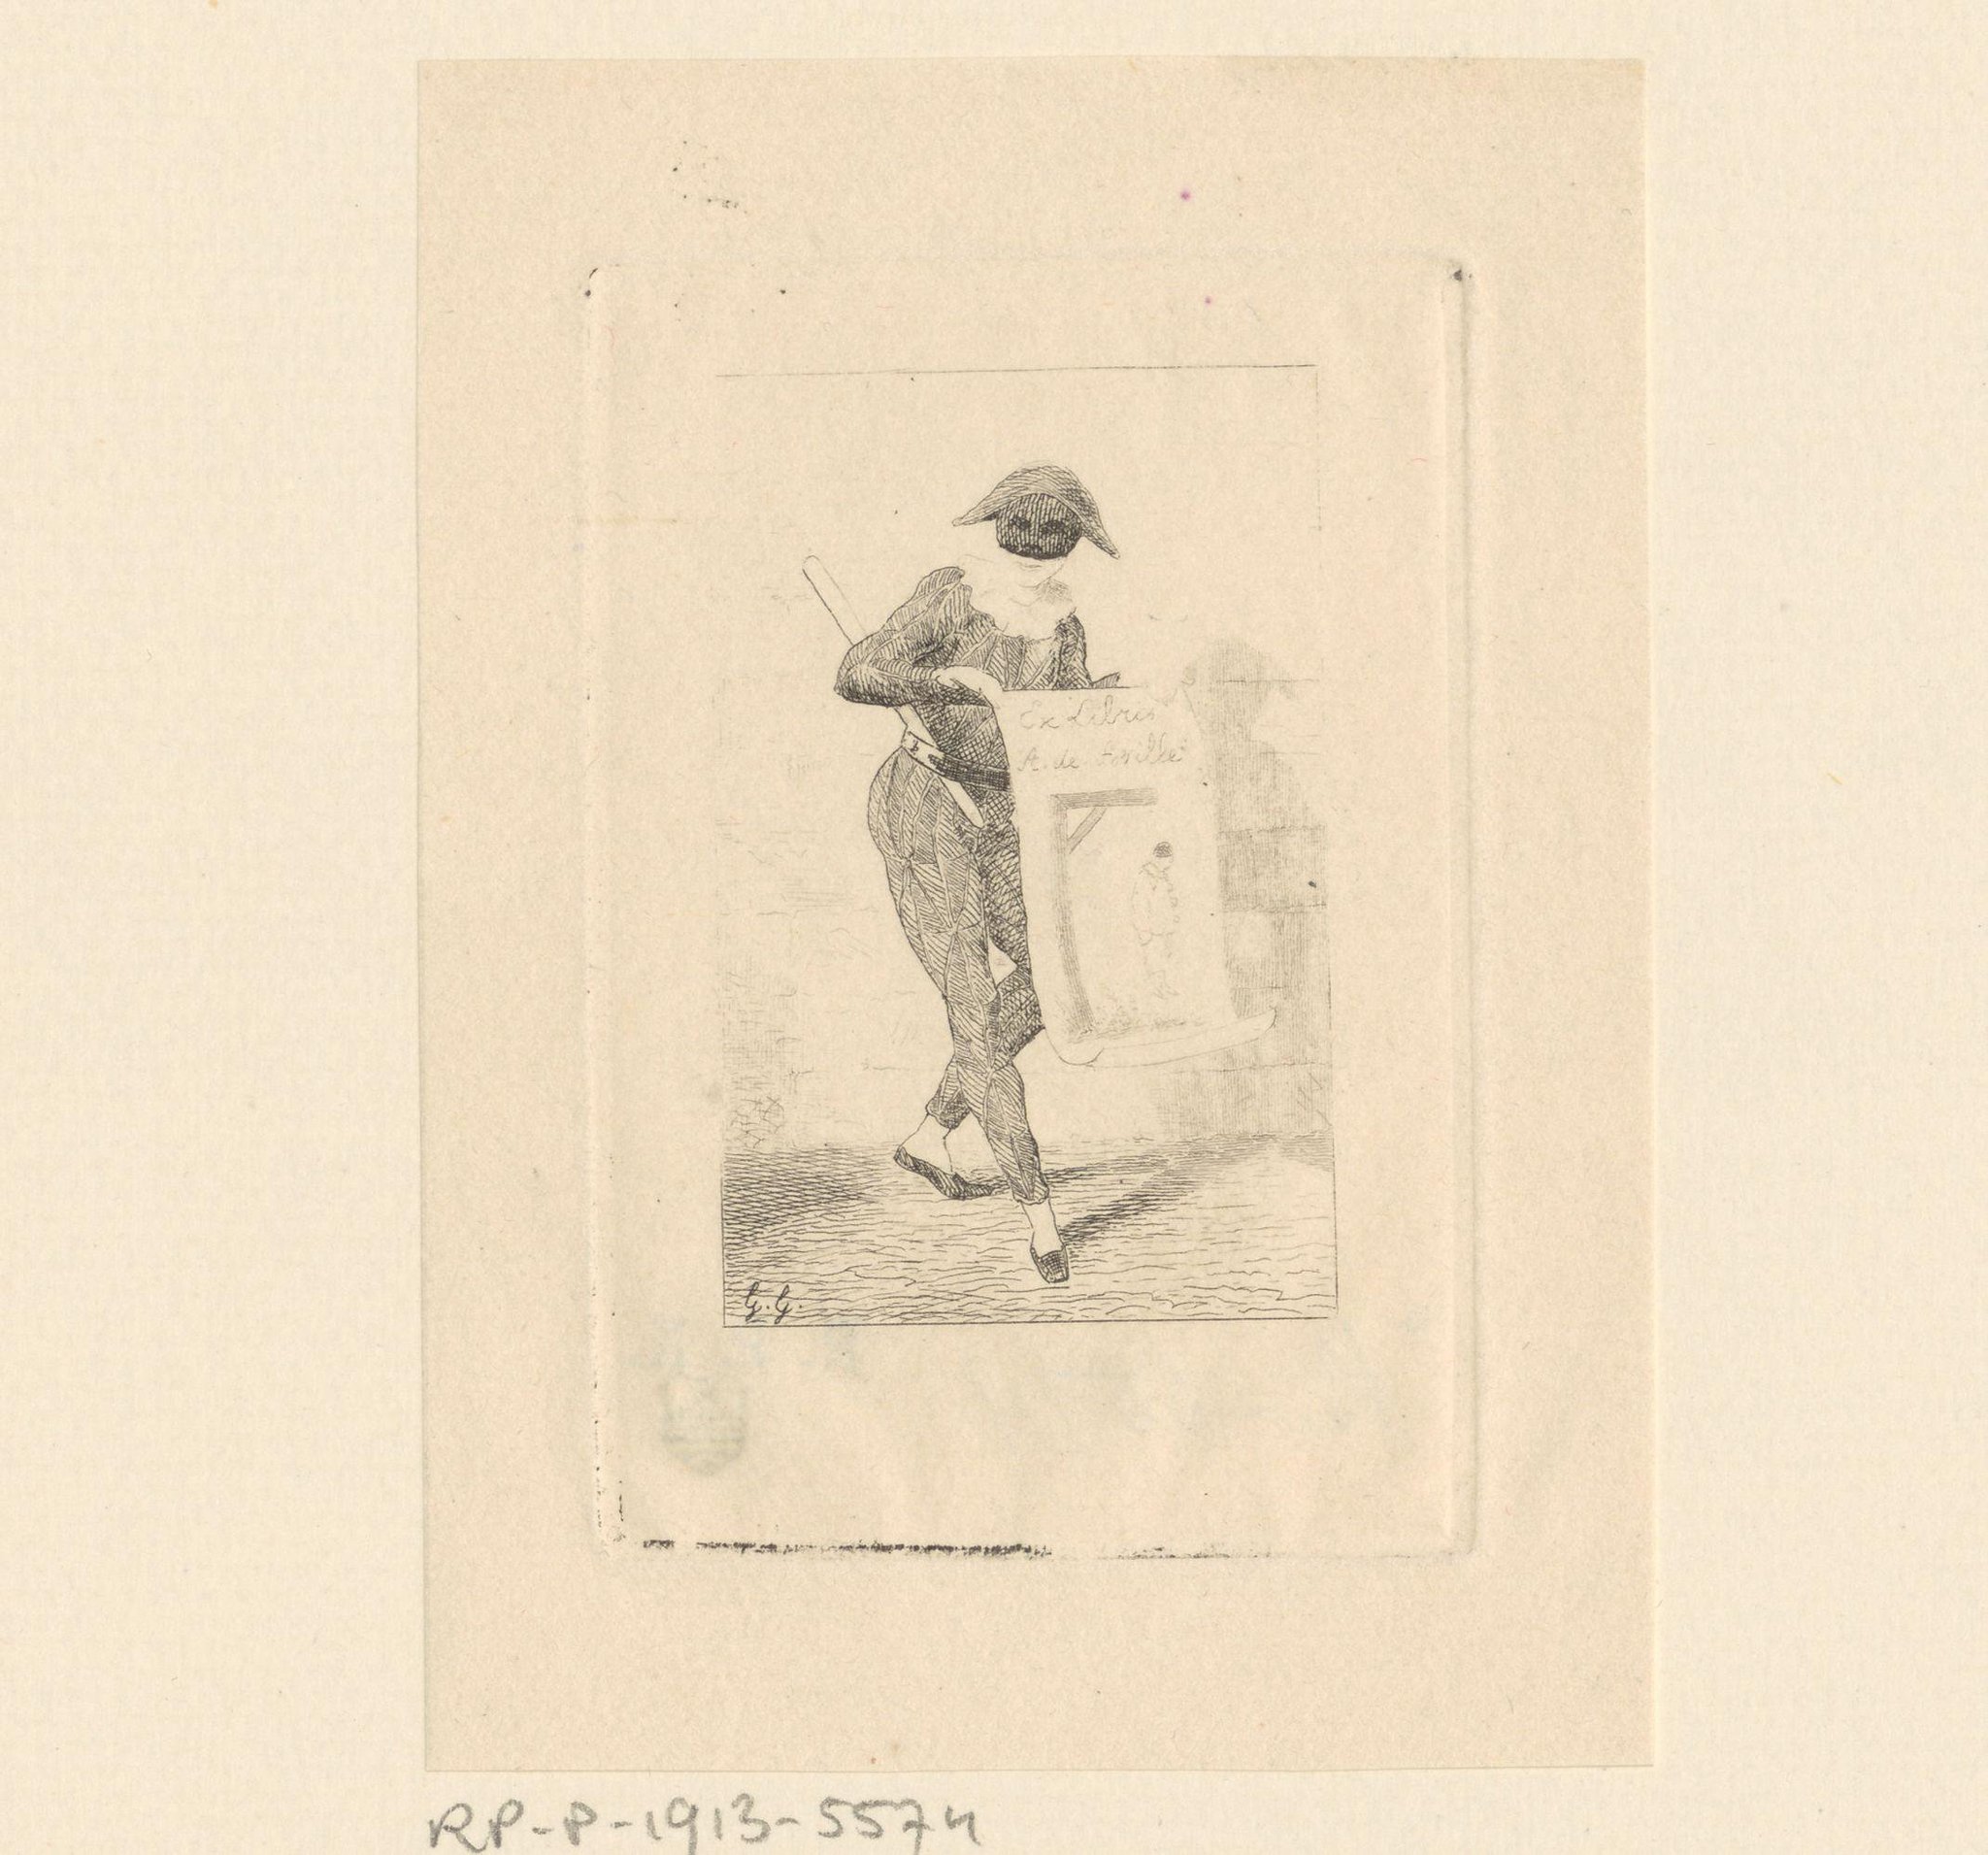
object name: bookplate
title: Ex libris A. de Foville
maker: Anonymous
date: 1852-1913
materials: paper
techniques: etching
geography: france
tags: paris, instruments of torture, execution or punishment: gallows, court jester, court fool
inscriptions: collector's mark: Lugt 2760, collector's mark: Lugt 2233